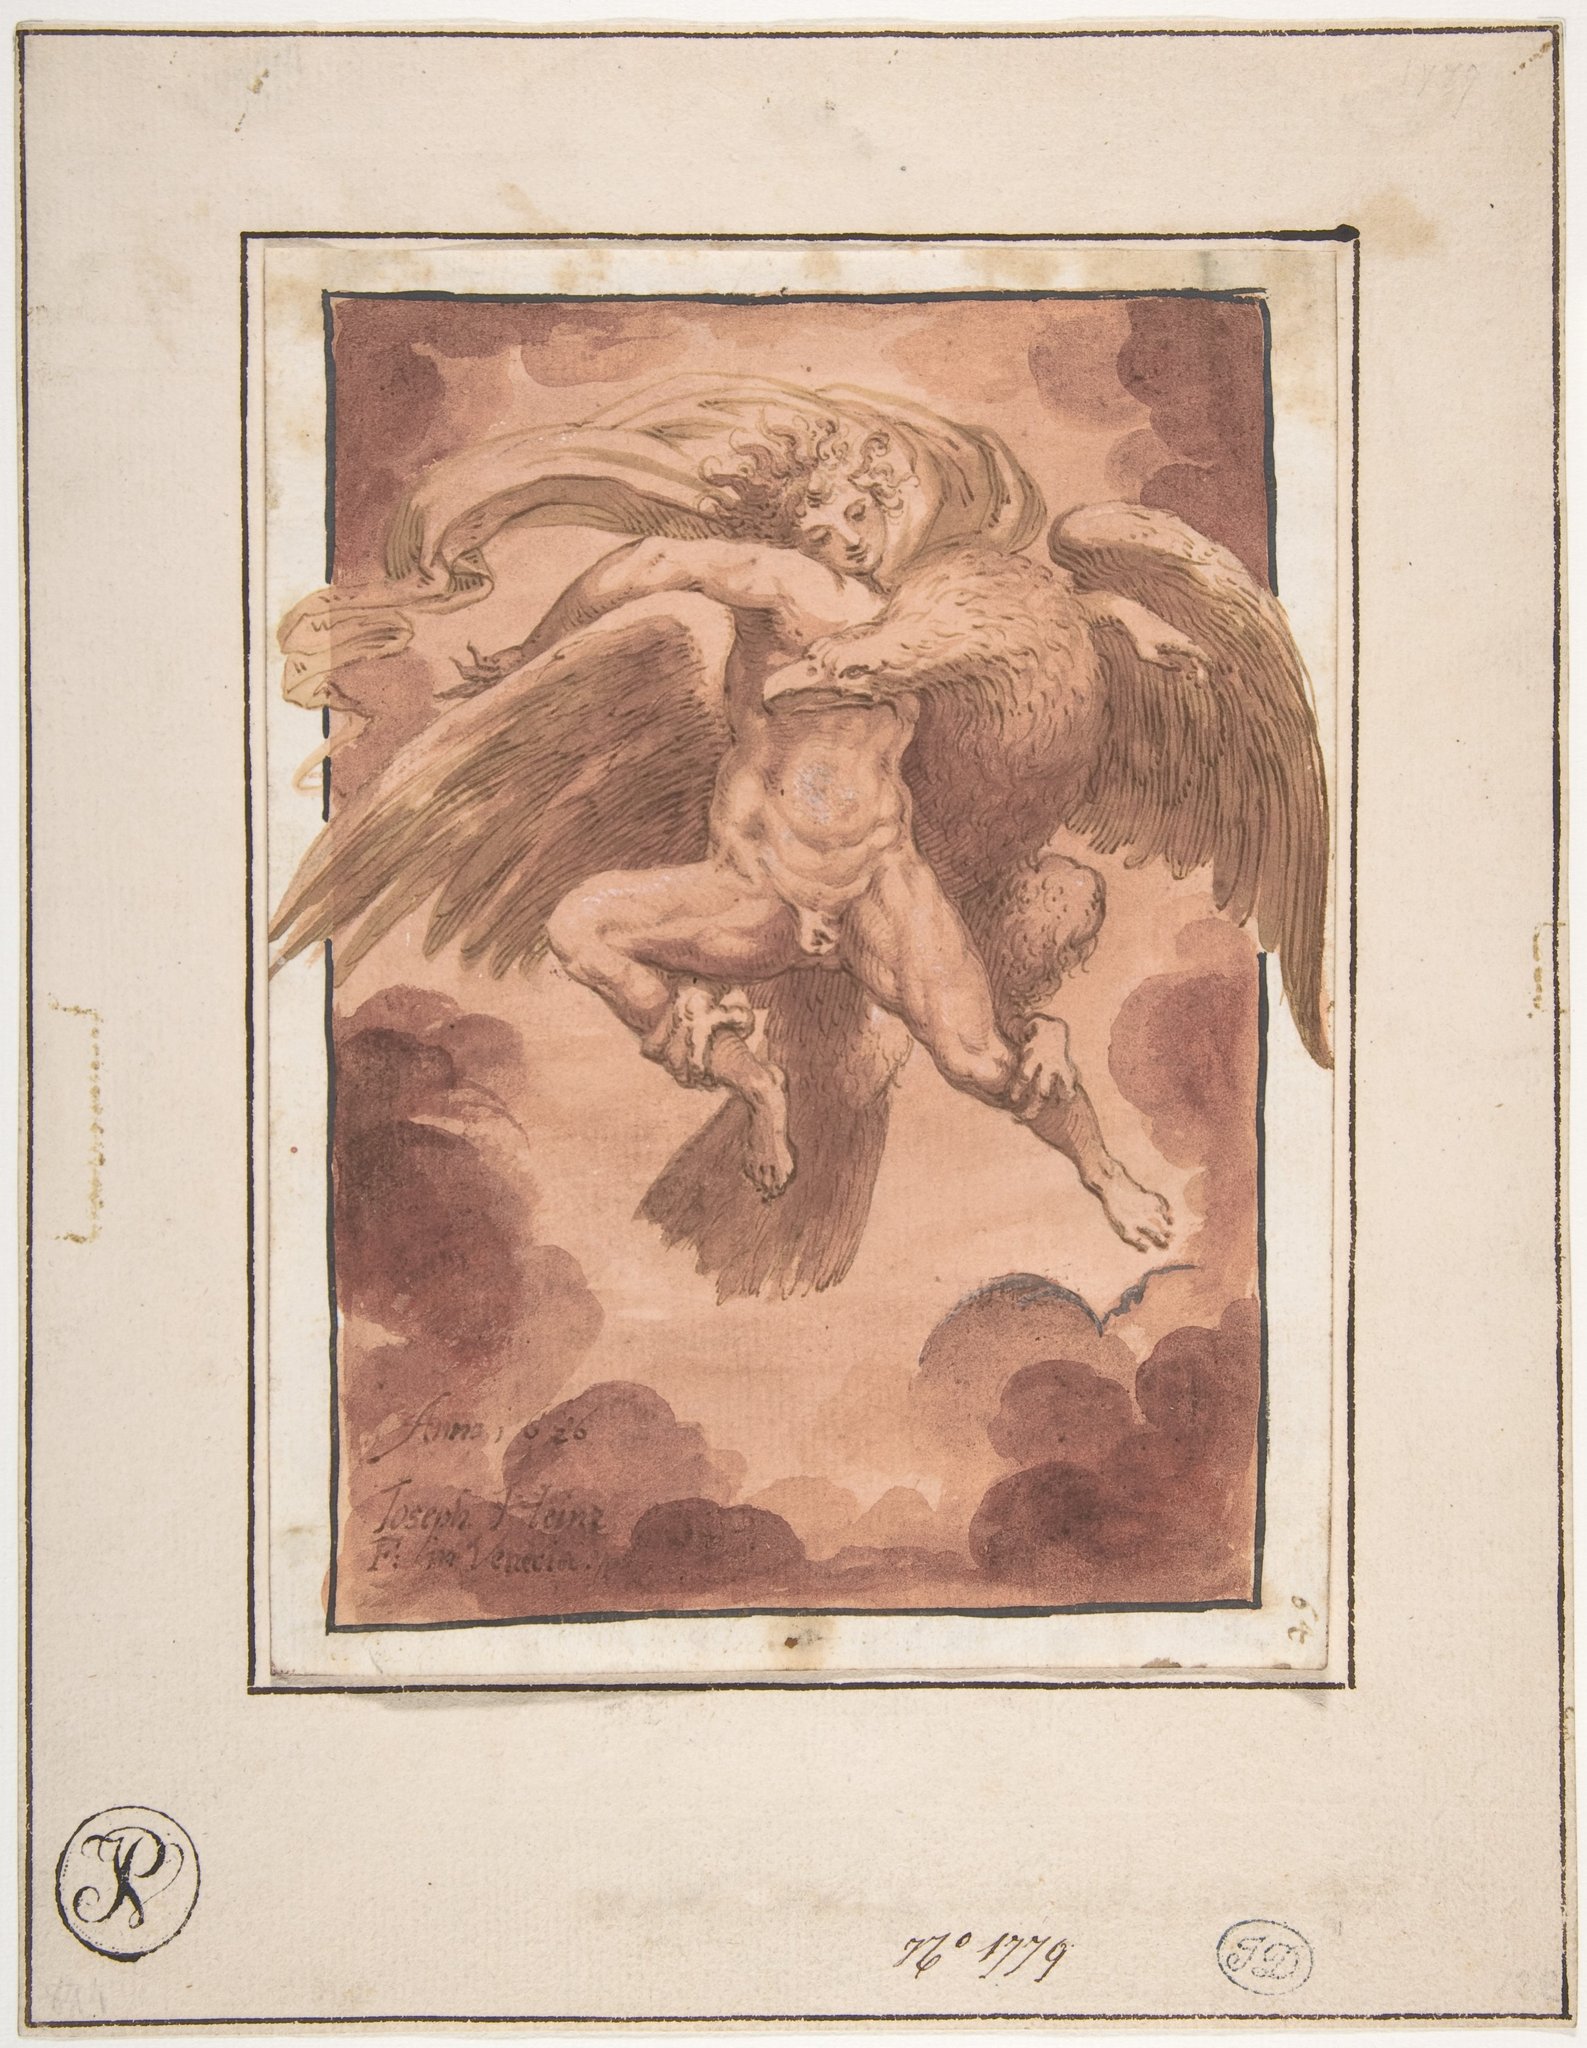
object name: drawing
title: Jupiter and Ganymede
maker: joseph heintz the younger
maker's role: artist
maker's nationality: german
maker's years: 1600-1678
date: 1626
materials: ink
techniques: heightening, pen, wash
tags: eagles,jupiter